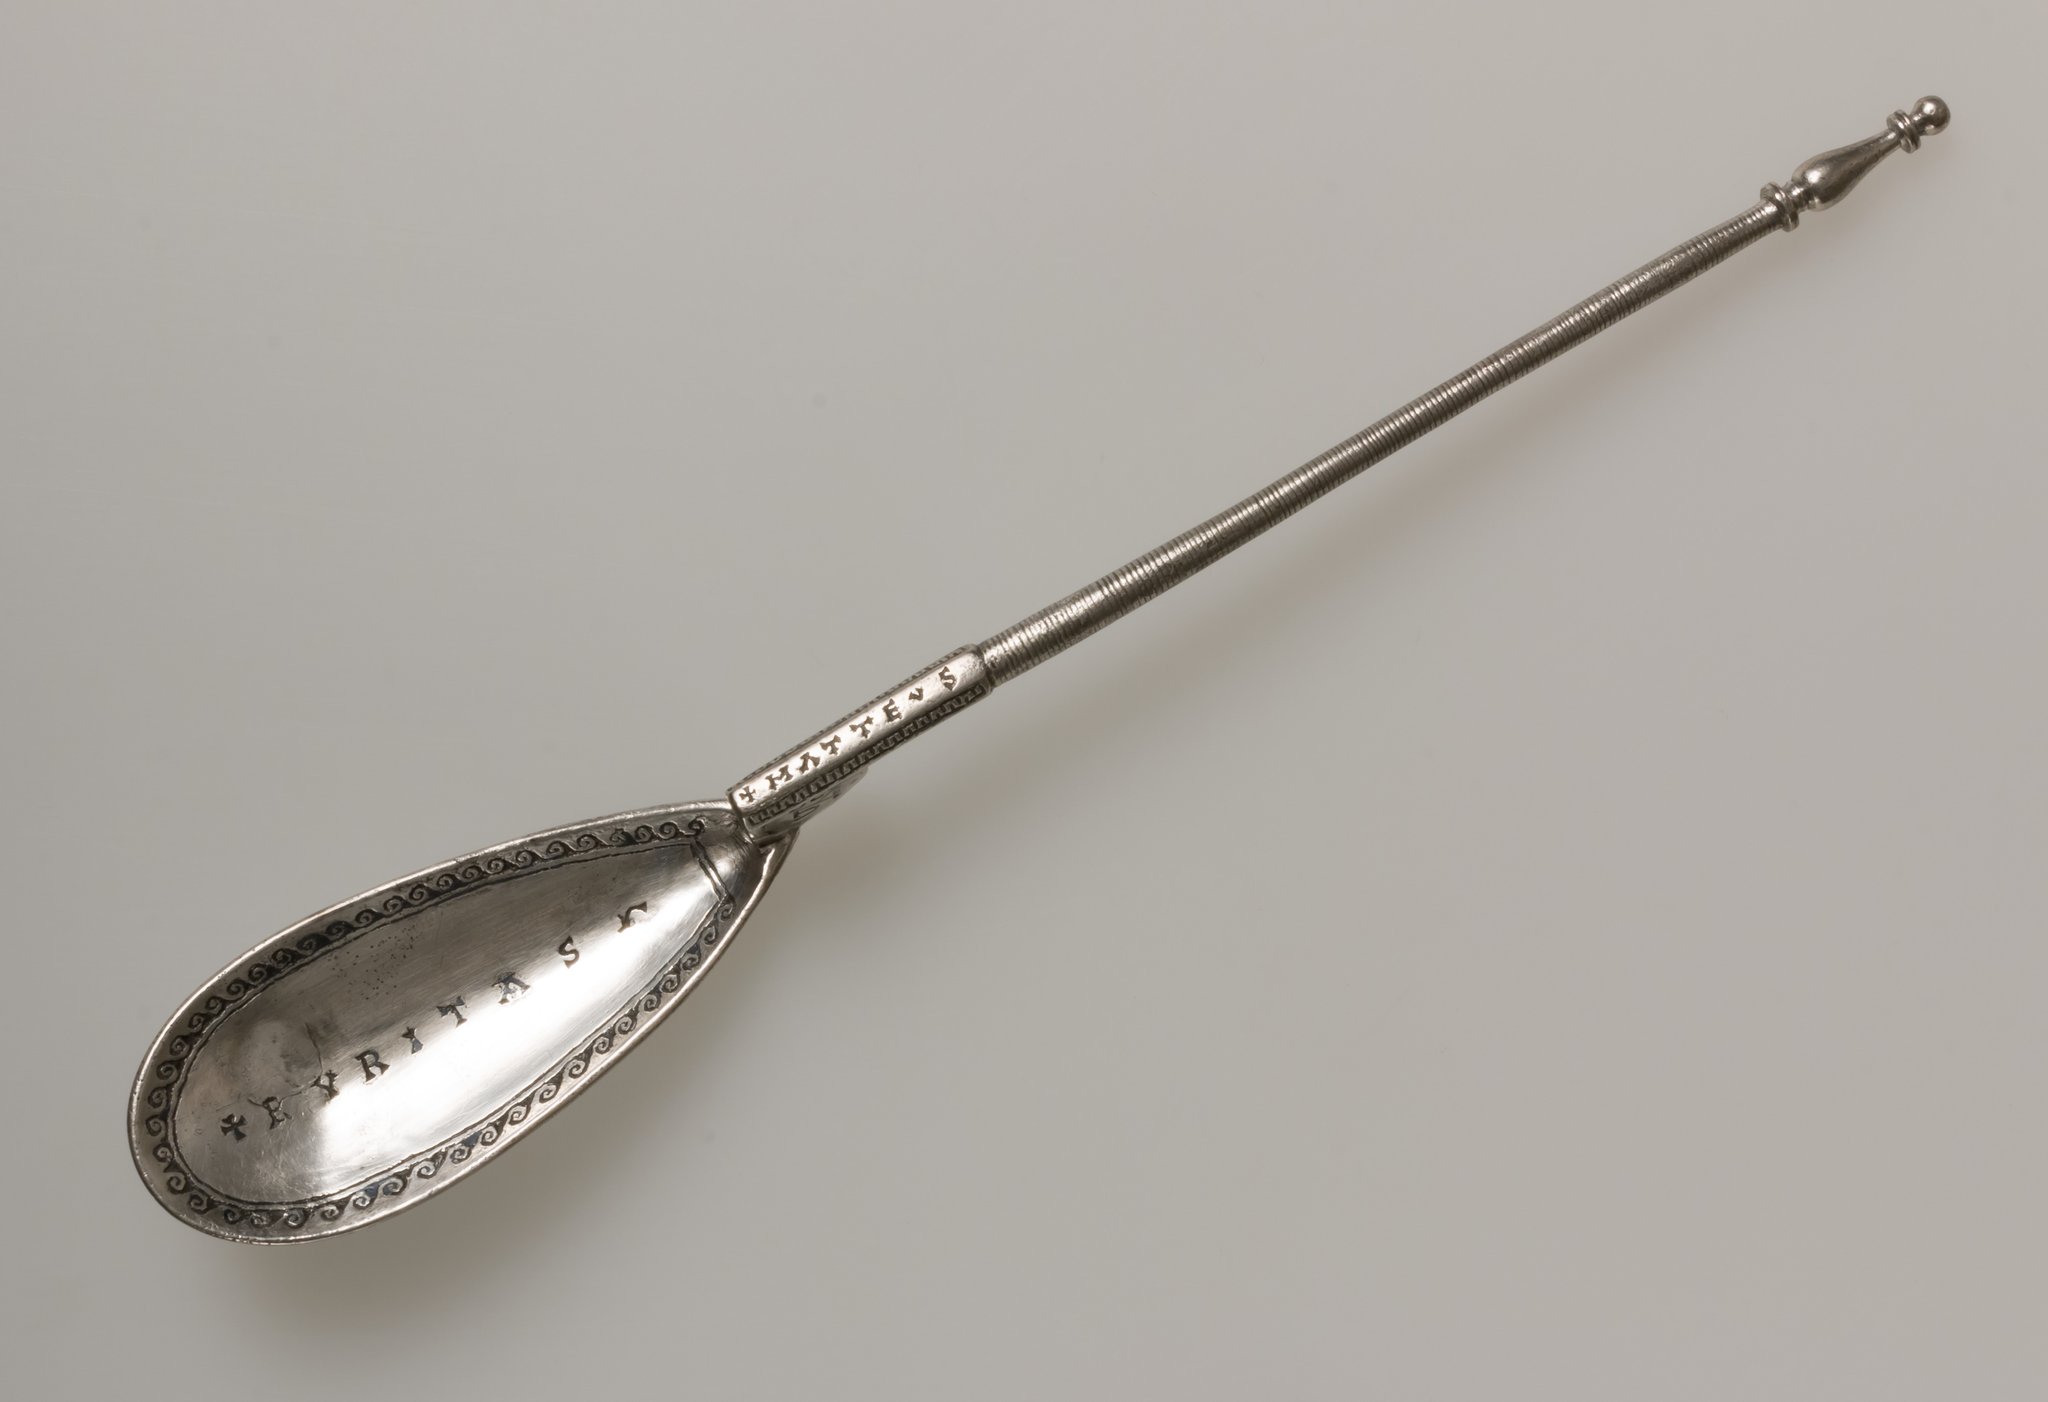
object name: spoon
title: Silver Spoon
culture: byzantine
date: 534-666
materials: niello, silver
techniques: gilding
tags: latin